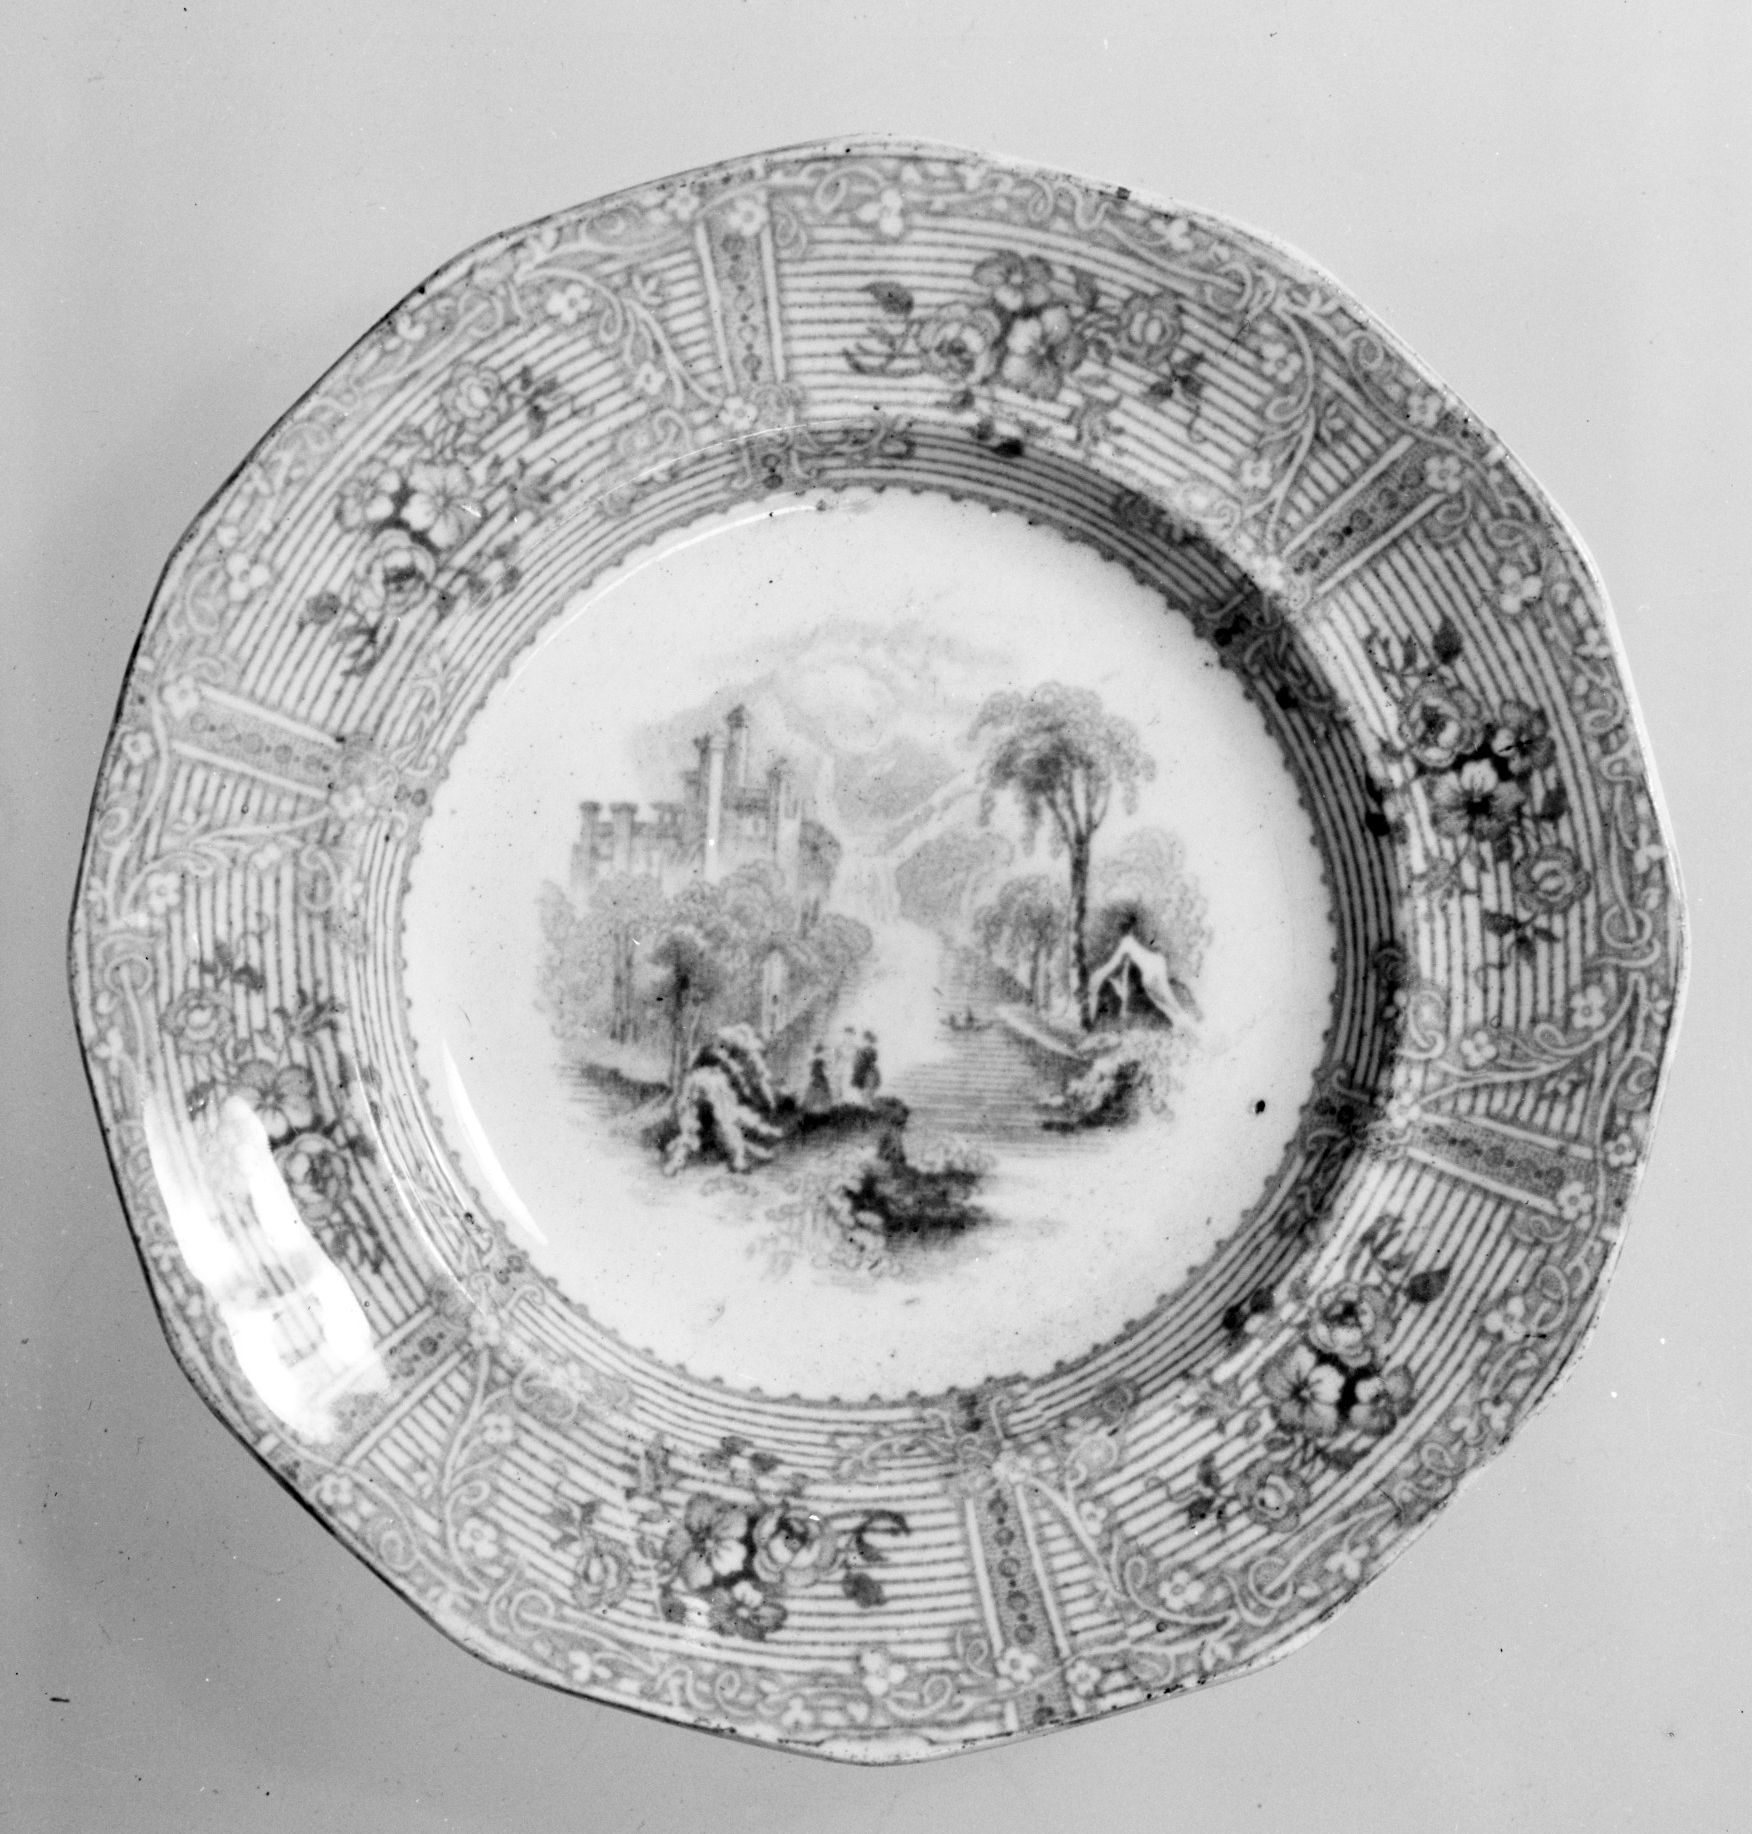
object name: plate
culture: british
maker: joseph heath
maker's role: maker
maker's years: 1842-1853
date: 1845-1853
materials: earthenware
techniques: transfer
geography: england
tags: landscapes